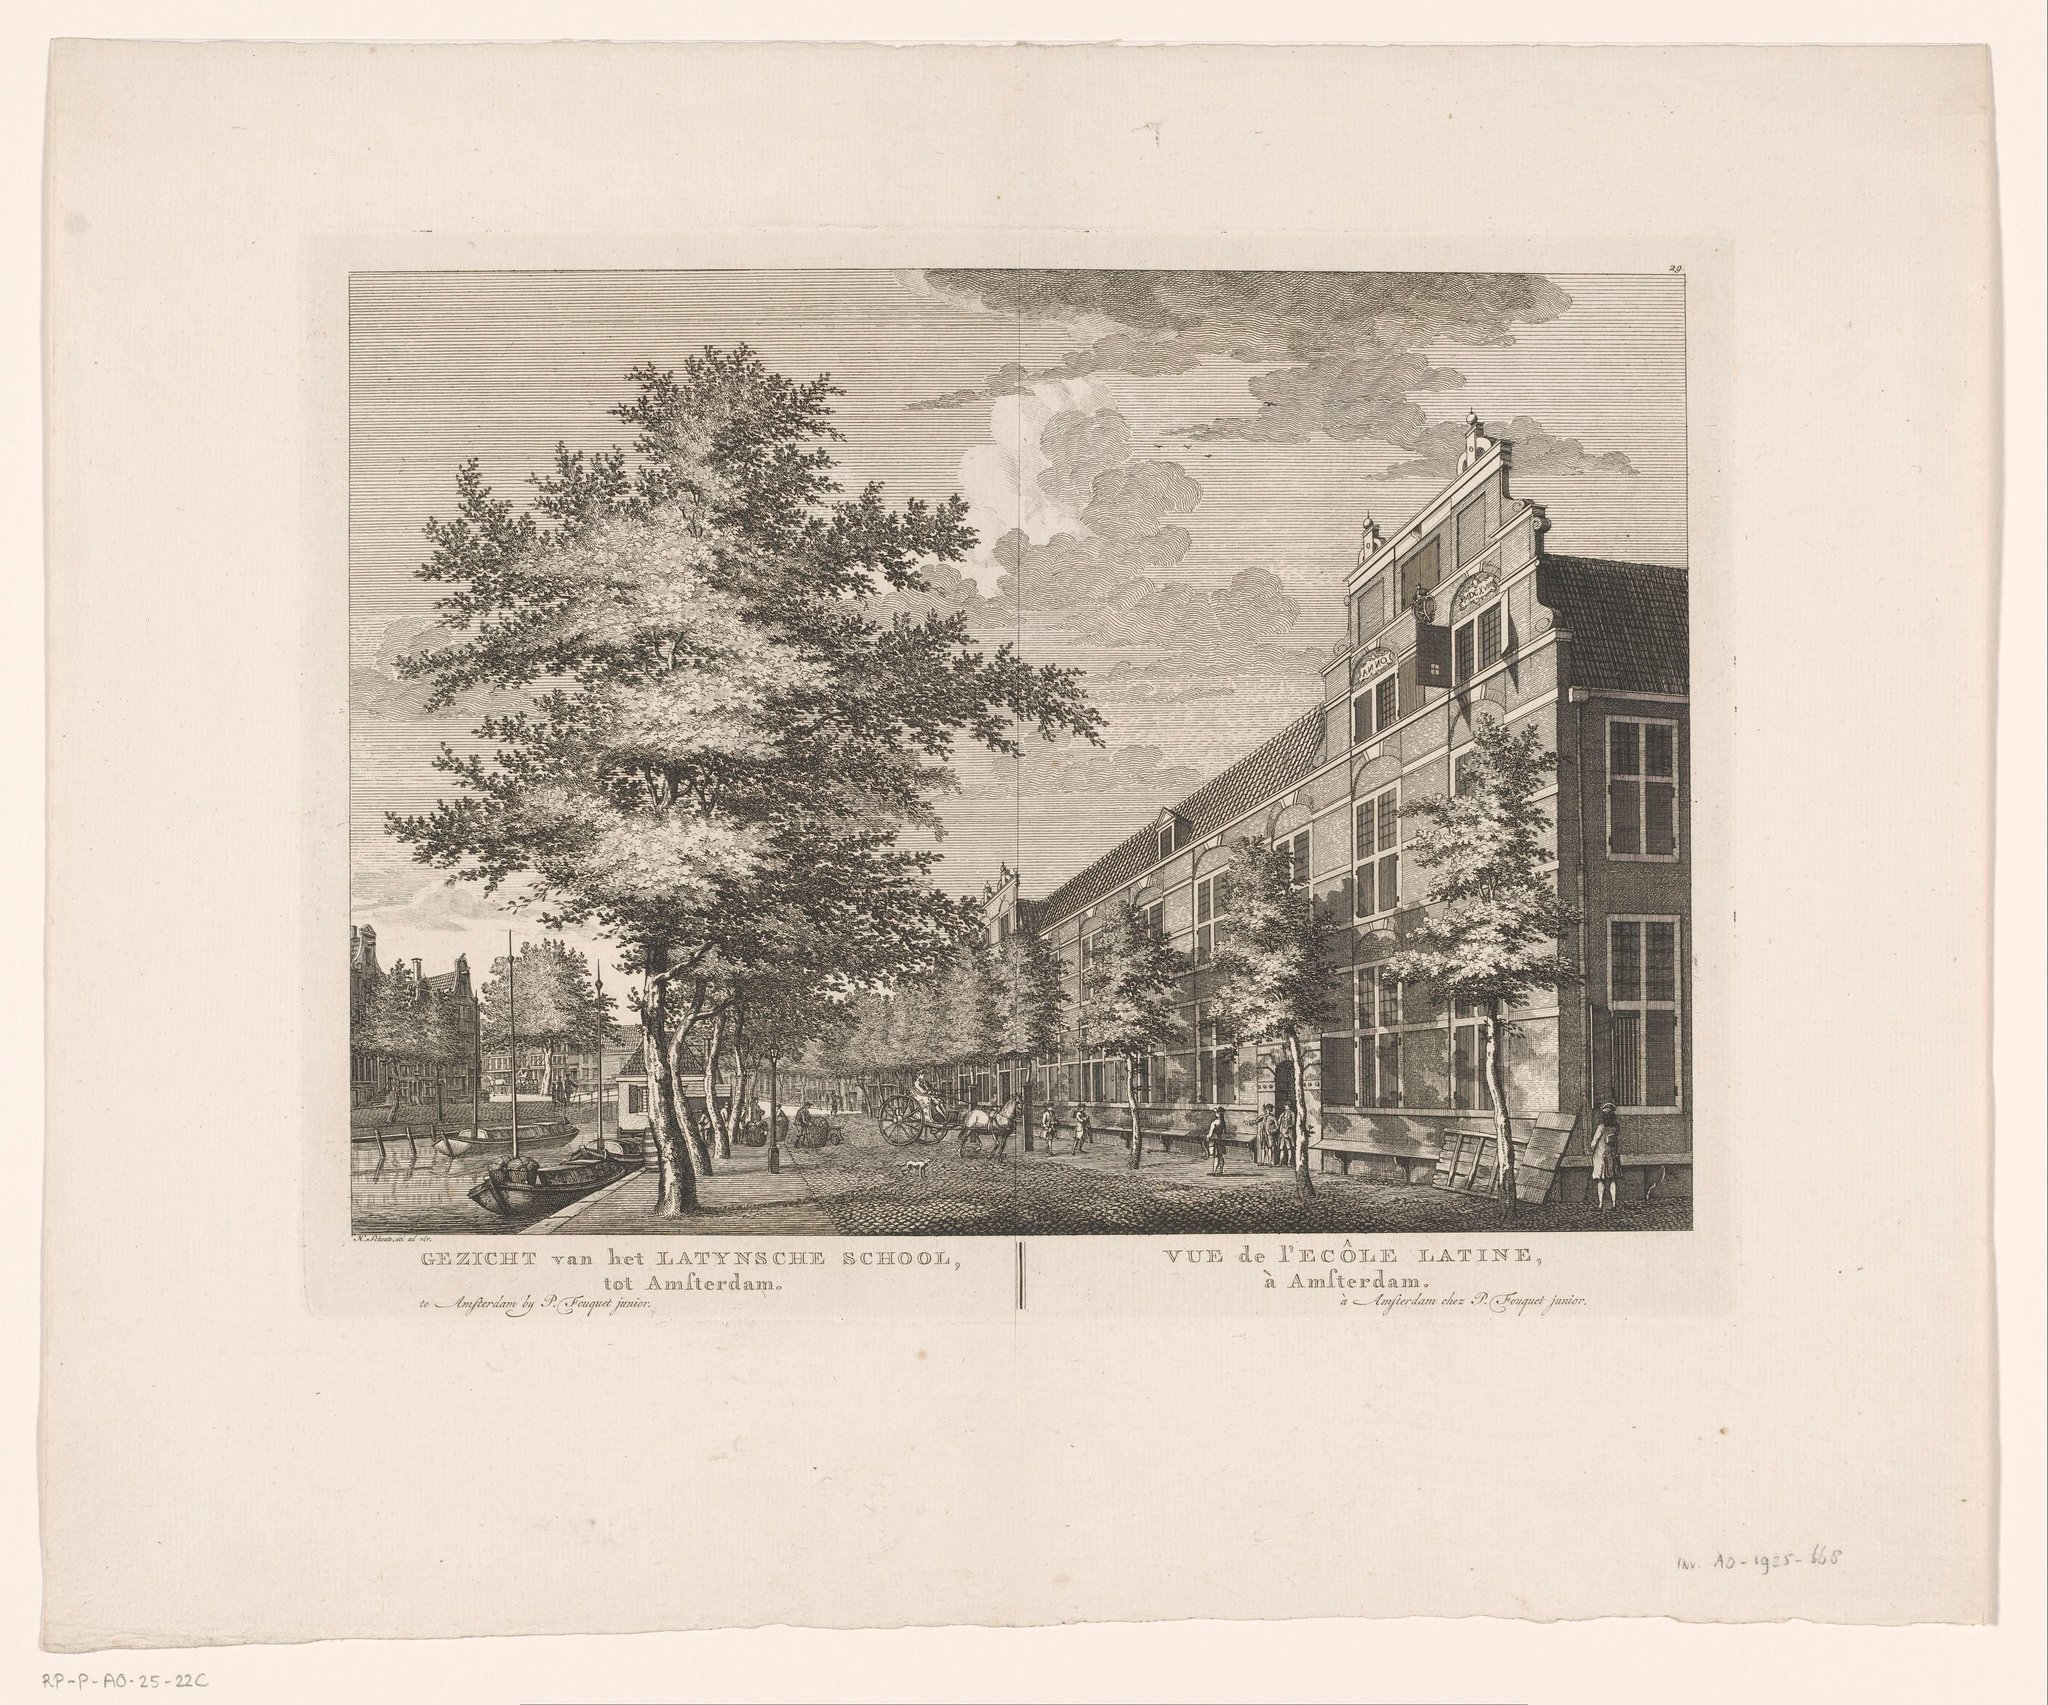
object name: print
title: Gezicht van het Latynsche School, tot Amsterdam / Vue de l'Ecôle Latine, à Amsterdam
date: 1770-1783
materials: paper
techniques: engraving, etching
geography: amsterdam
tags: secondary education (+ building ~ education, tuition), canals, waters (in city) (+ city(-scape) with figures, staffage), street (+ city(-scape) with figures, staffage)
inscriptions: collector's mark: Lugt 2228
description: Deze prent is ook gebruikt in de zogenaamde Atlas van Fouquet.* Pierre Fouquet gaf vanaf 1760 stadsgezichten van Amsterdam - naar tekeningen van verschillende kunstenaars, gemaakt door verschillende prentmakers - uit. Deze prenten werden aanvankelijk los of in series verkocht. Zoals toen gebruikelijk kon de koper de prenten zelf laten inbinden. Hiertoe gaf Fouquet tussen 1778 en 1783 een titelblad, plattegrond en inhoudsopgave van de tot dusver 100 uitgegeven prenten uit (1). Gezien de inhoud afhankelijk was van wat de koper had verzameld verschilt de inhoud van de verschillende bewaarde Fouquetatlassen onder deze titel sterk. Ook zijn er exemplaren bekend waar tevens andere prenten aan zijn toegevoegd. Omdat er behoefte bleek aan uitleg bij de platen werd in 1783 een nieuwe versie van de atlas uitgegeven, aangevuld met tekst en twee prenten. De aangegeven volgorde veranderde maar de platen van de al eerder uitgegeven prenten bleven ongewijzigd. Deze uitgave werd in opdracht van Fouquet gedrukt bij Daniël Jean Changuion en Petrus den Hengst (2). Een tiental platen werd bijgewerkt en verscheen, met nieuw impressum, in het vervolg van Wagenaars geschiedenis van Amsterdam, uitgeven door Petrus Conradi en Folkert van der Plaats (3). Een aantal jaar na het overlijden van Fouquet kwam Evert Maaskamp met een nieuwe uitgave van de atlas, met verbeterde tekst en toevoeging van twee prenten. Op alle platen verwijderde hij het oude en liet hij zijn eigen impressum zetten (4). De huidige staat van de prent komt voor in exemplaren van de onder (1) en (2) genoemde werken. * Onder de Atlas van Fouquet of Fouquetatlas verstaan we de hieronder vermelde publicaties (1), (2) en (4). (1). Afbeeldingen van de wyd-vermaarde koopstad Amsterdam benevens des zelvs voornaamste gebouwen en gezigten alle naar het leeven getekend / Receuil des edifices les plus considerables et des plus belles vues, de la fameuse ville d'Amsterdam, dessinées d'après nature. Amsterdam: Pierre Fouquet, 1778-1783. (2). Nieuwe atlas, van de voornaamste gebouwen en gezigten der stad Amsterdam, met derzelver beknopte beschryvingen. 2 delen. Amsterdam: Daniël Jean Changuion en Petrus den Hengst [in opdracht van Pierre Fouquet], 1783. (3). Stijl, Simon. Amsterdam, in zyne geschiedenissen, voorregten, koophandel, gebouwen, kerkenstaat, schoolen, schutterye, gilden en regeeringe, beschreeven. Om te dienen ten vervolge op het werk van Jan Wagenaar (…). 10 delen. Amsterdam en Harlingen: Petrus Conradi en Folkert van der Plaats, 1788-1801. (4). Nieuwe atlas, van de voornaamste gebouwen en gezigten der stad Amsterdam. Met derzelver beknopte beschryvingen. Amsterdam: Evert Maaskamp, 1805. * Het aantal vermelde staten is gebaseerd op het aantal gevonden staten. Mogelijk zijn er meer staten van deze prent.